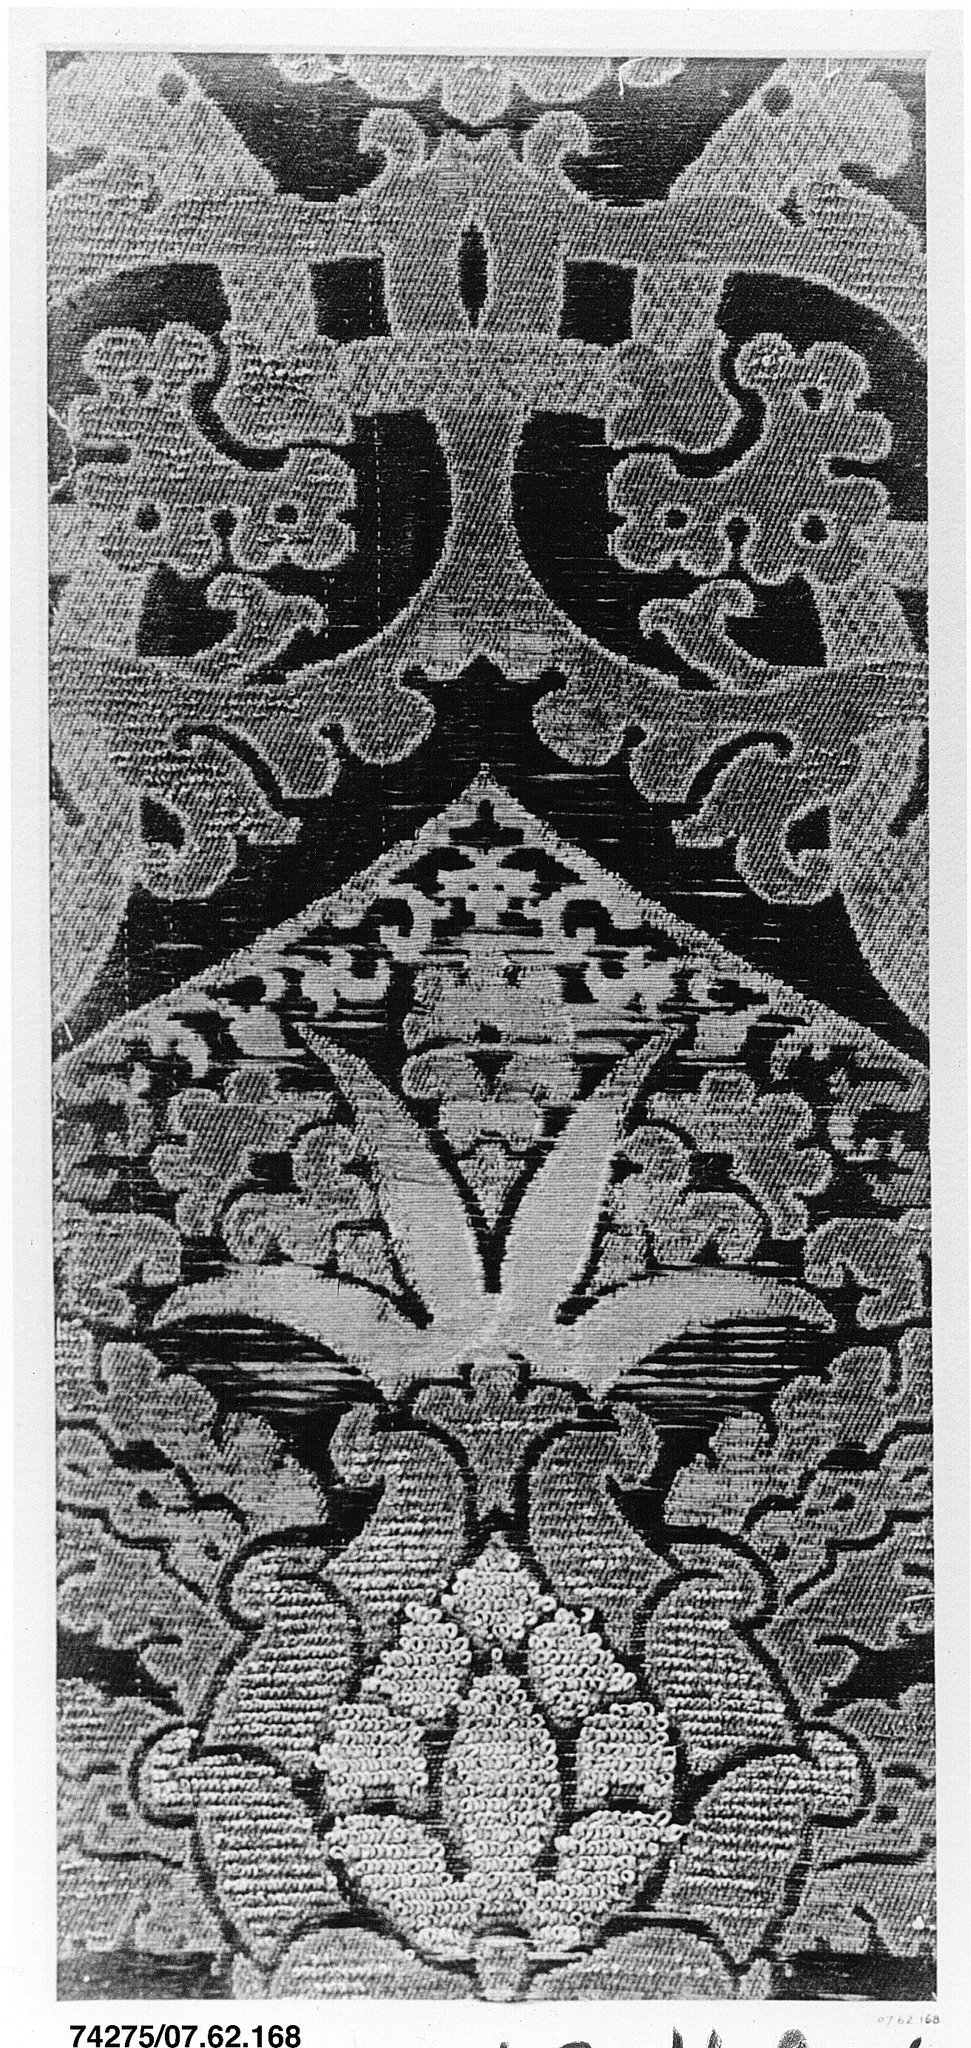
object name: piece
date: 1401-1600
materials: hemp, metal thread, silk